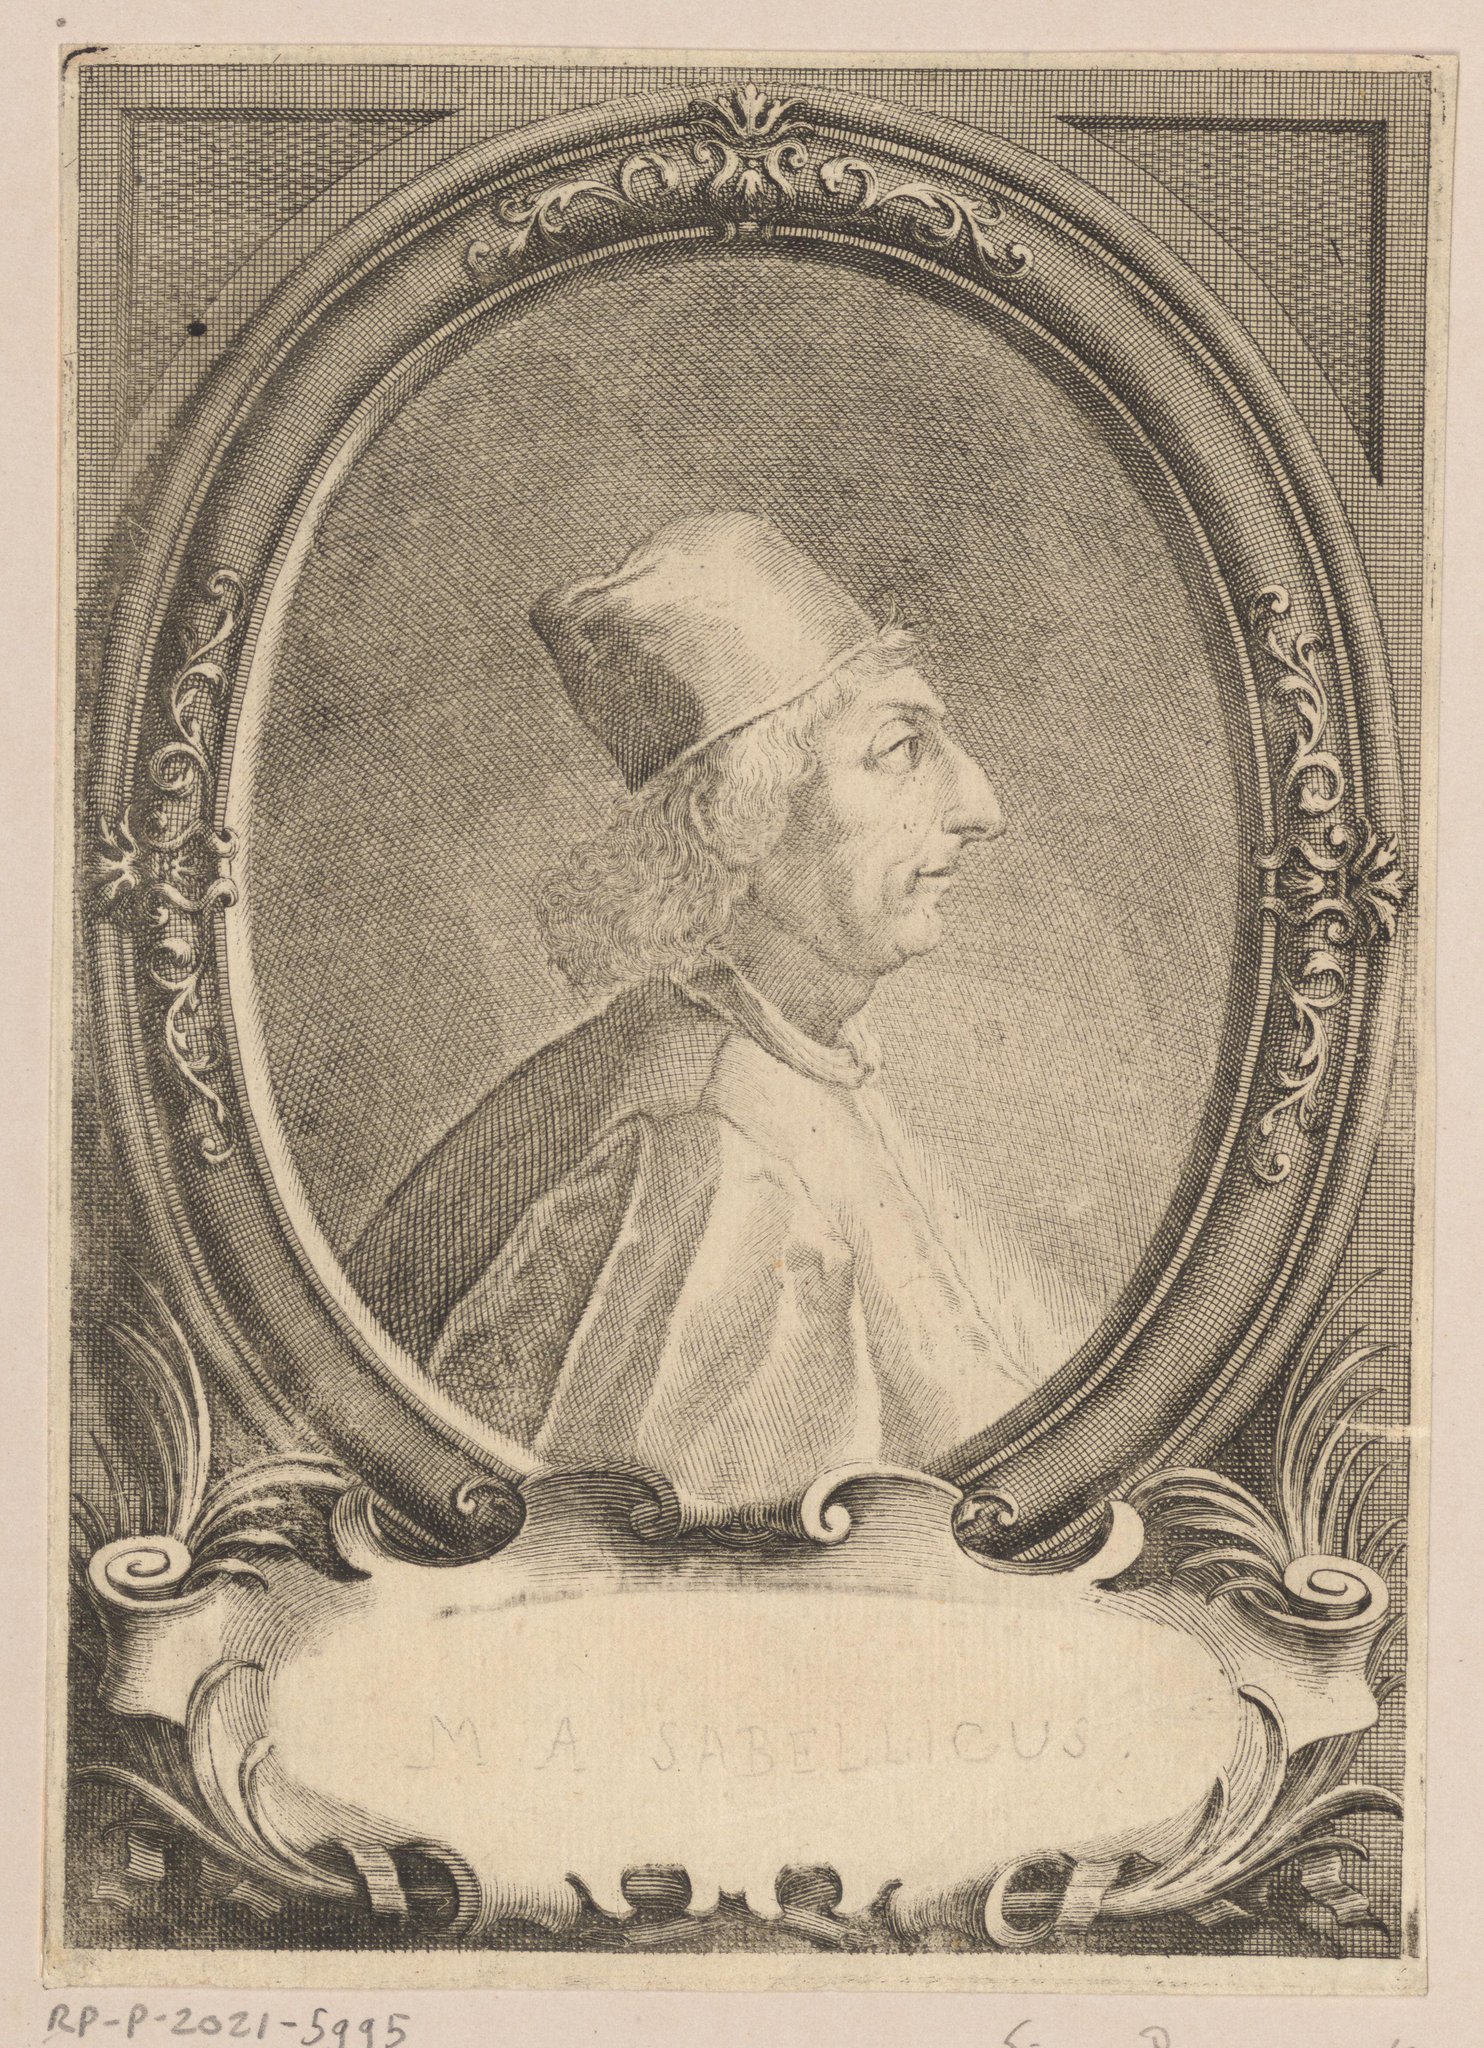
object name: print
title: Portret van Marcus Antonius Coccius Sabellicus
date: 1718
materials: paper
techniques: etching, letterpress printing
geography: venice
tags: historical persons, portrait of a writer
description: Prent uit: Sabellicus, Marcus Antonius Coccius. Degl' istorici delle cose Veneziane (...). Venetië: Domenico Lovisa, 1718. Latere staat van prent in een latere editie van: Sabellicus, Marcus Antonius Coccius. Degl' istorici delle cose Veneziane (...). Venetië: Domenico Lovisa, 1718.